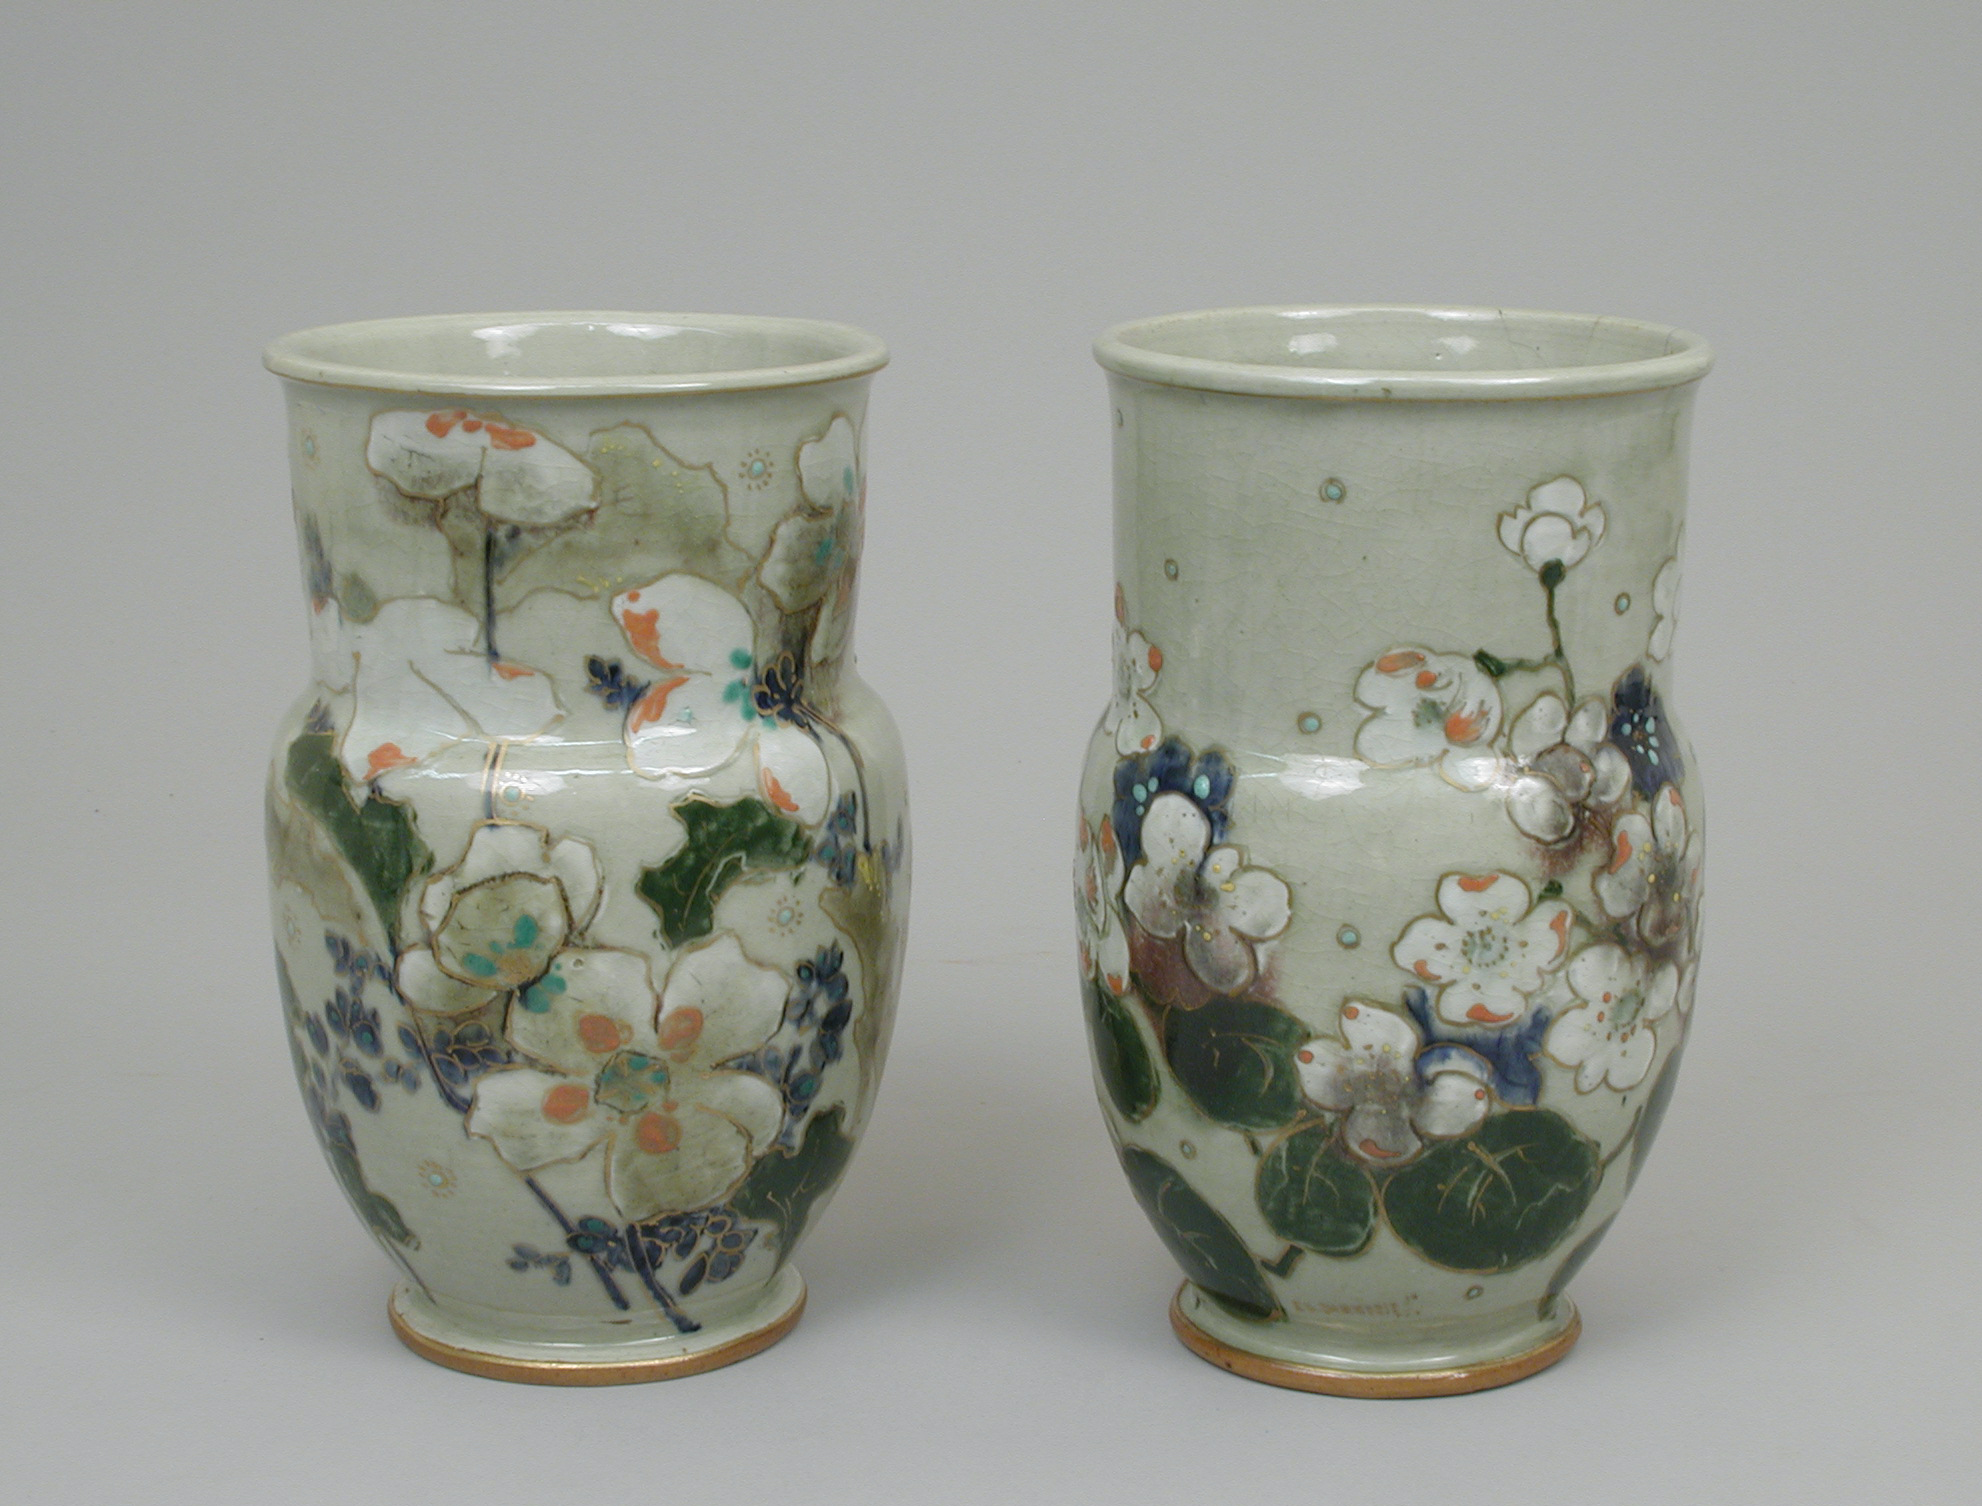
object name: vase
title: Pair of vases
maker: edouard-alexandre dammouse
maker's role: decorator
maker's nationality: french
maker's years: 1850-1903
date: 1882-1886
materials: clay, stoneware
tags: flowers